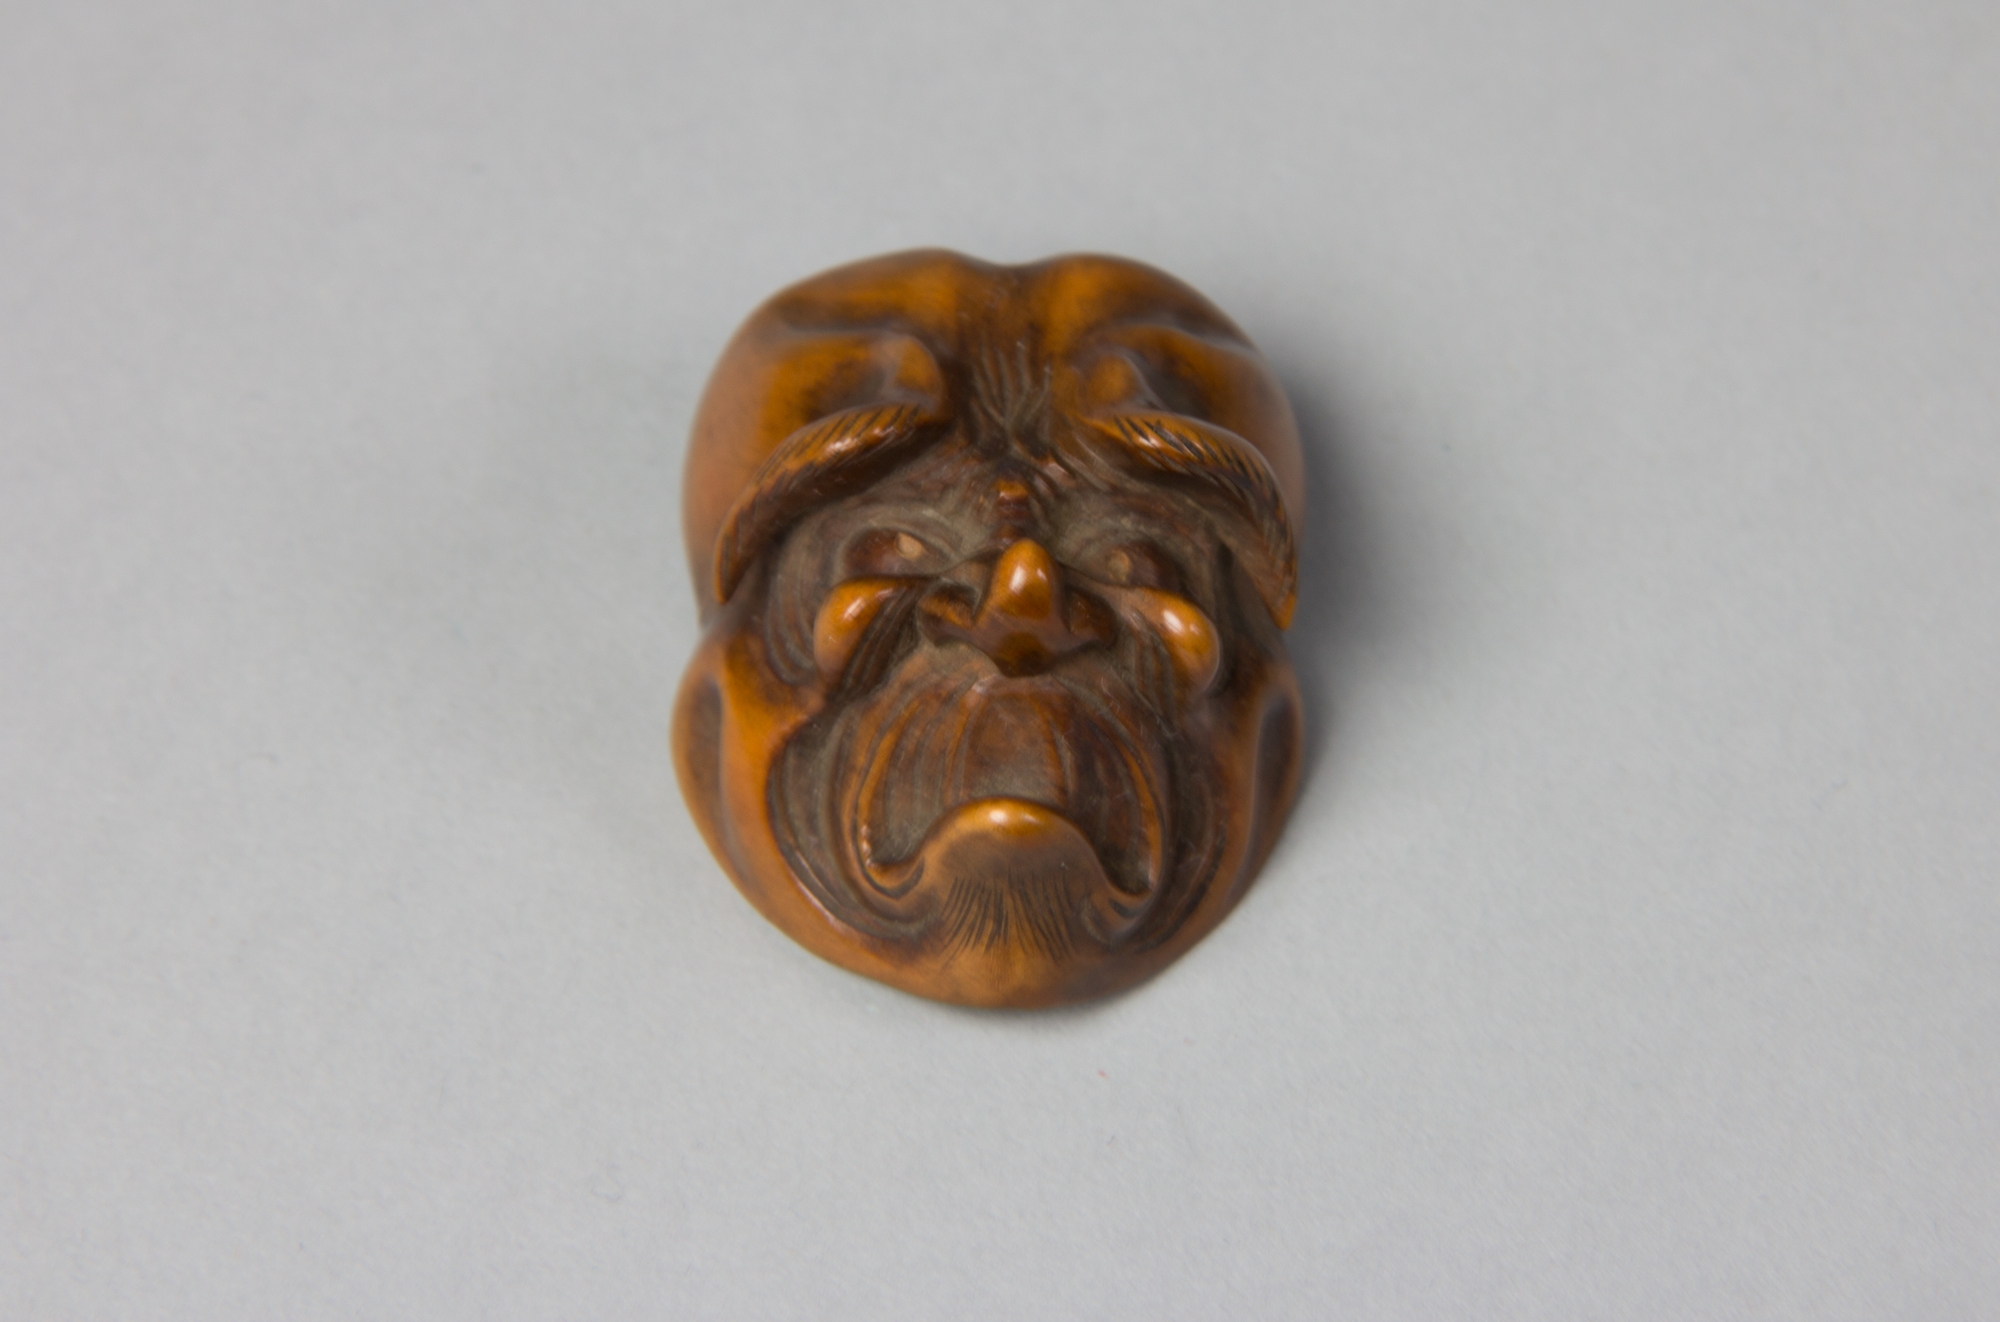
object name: netsuke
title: Netsuke: Mask of Unhappy Old Man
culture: japanese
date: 1801-1900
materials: wood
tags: masks,sadness,men